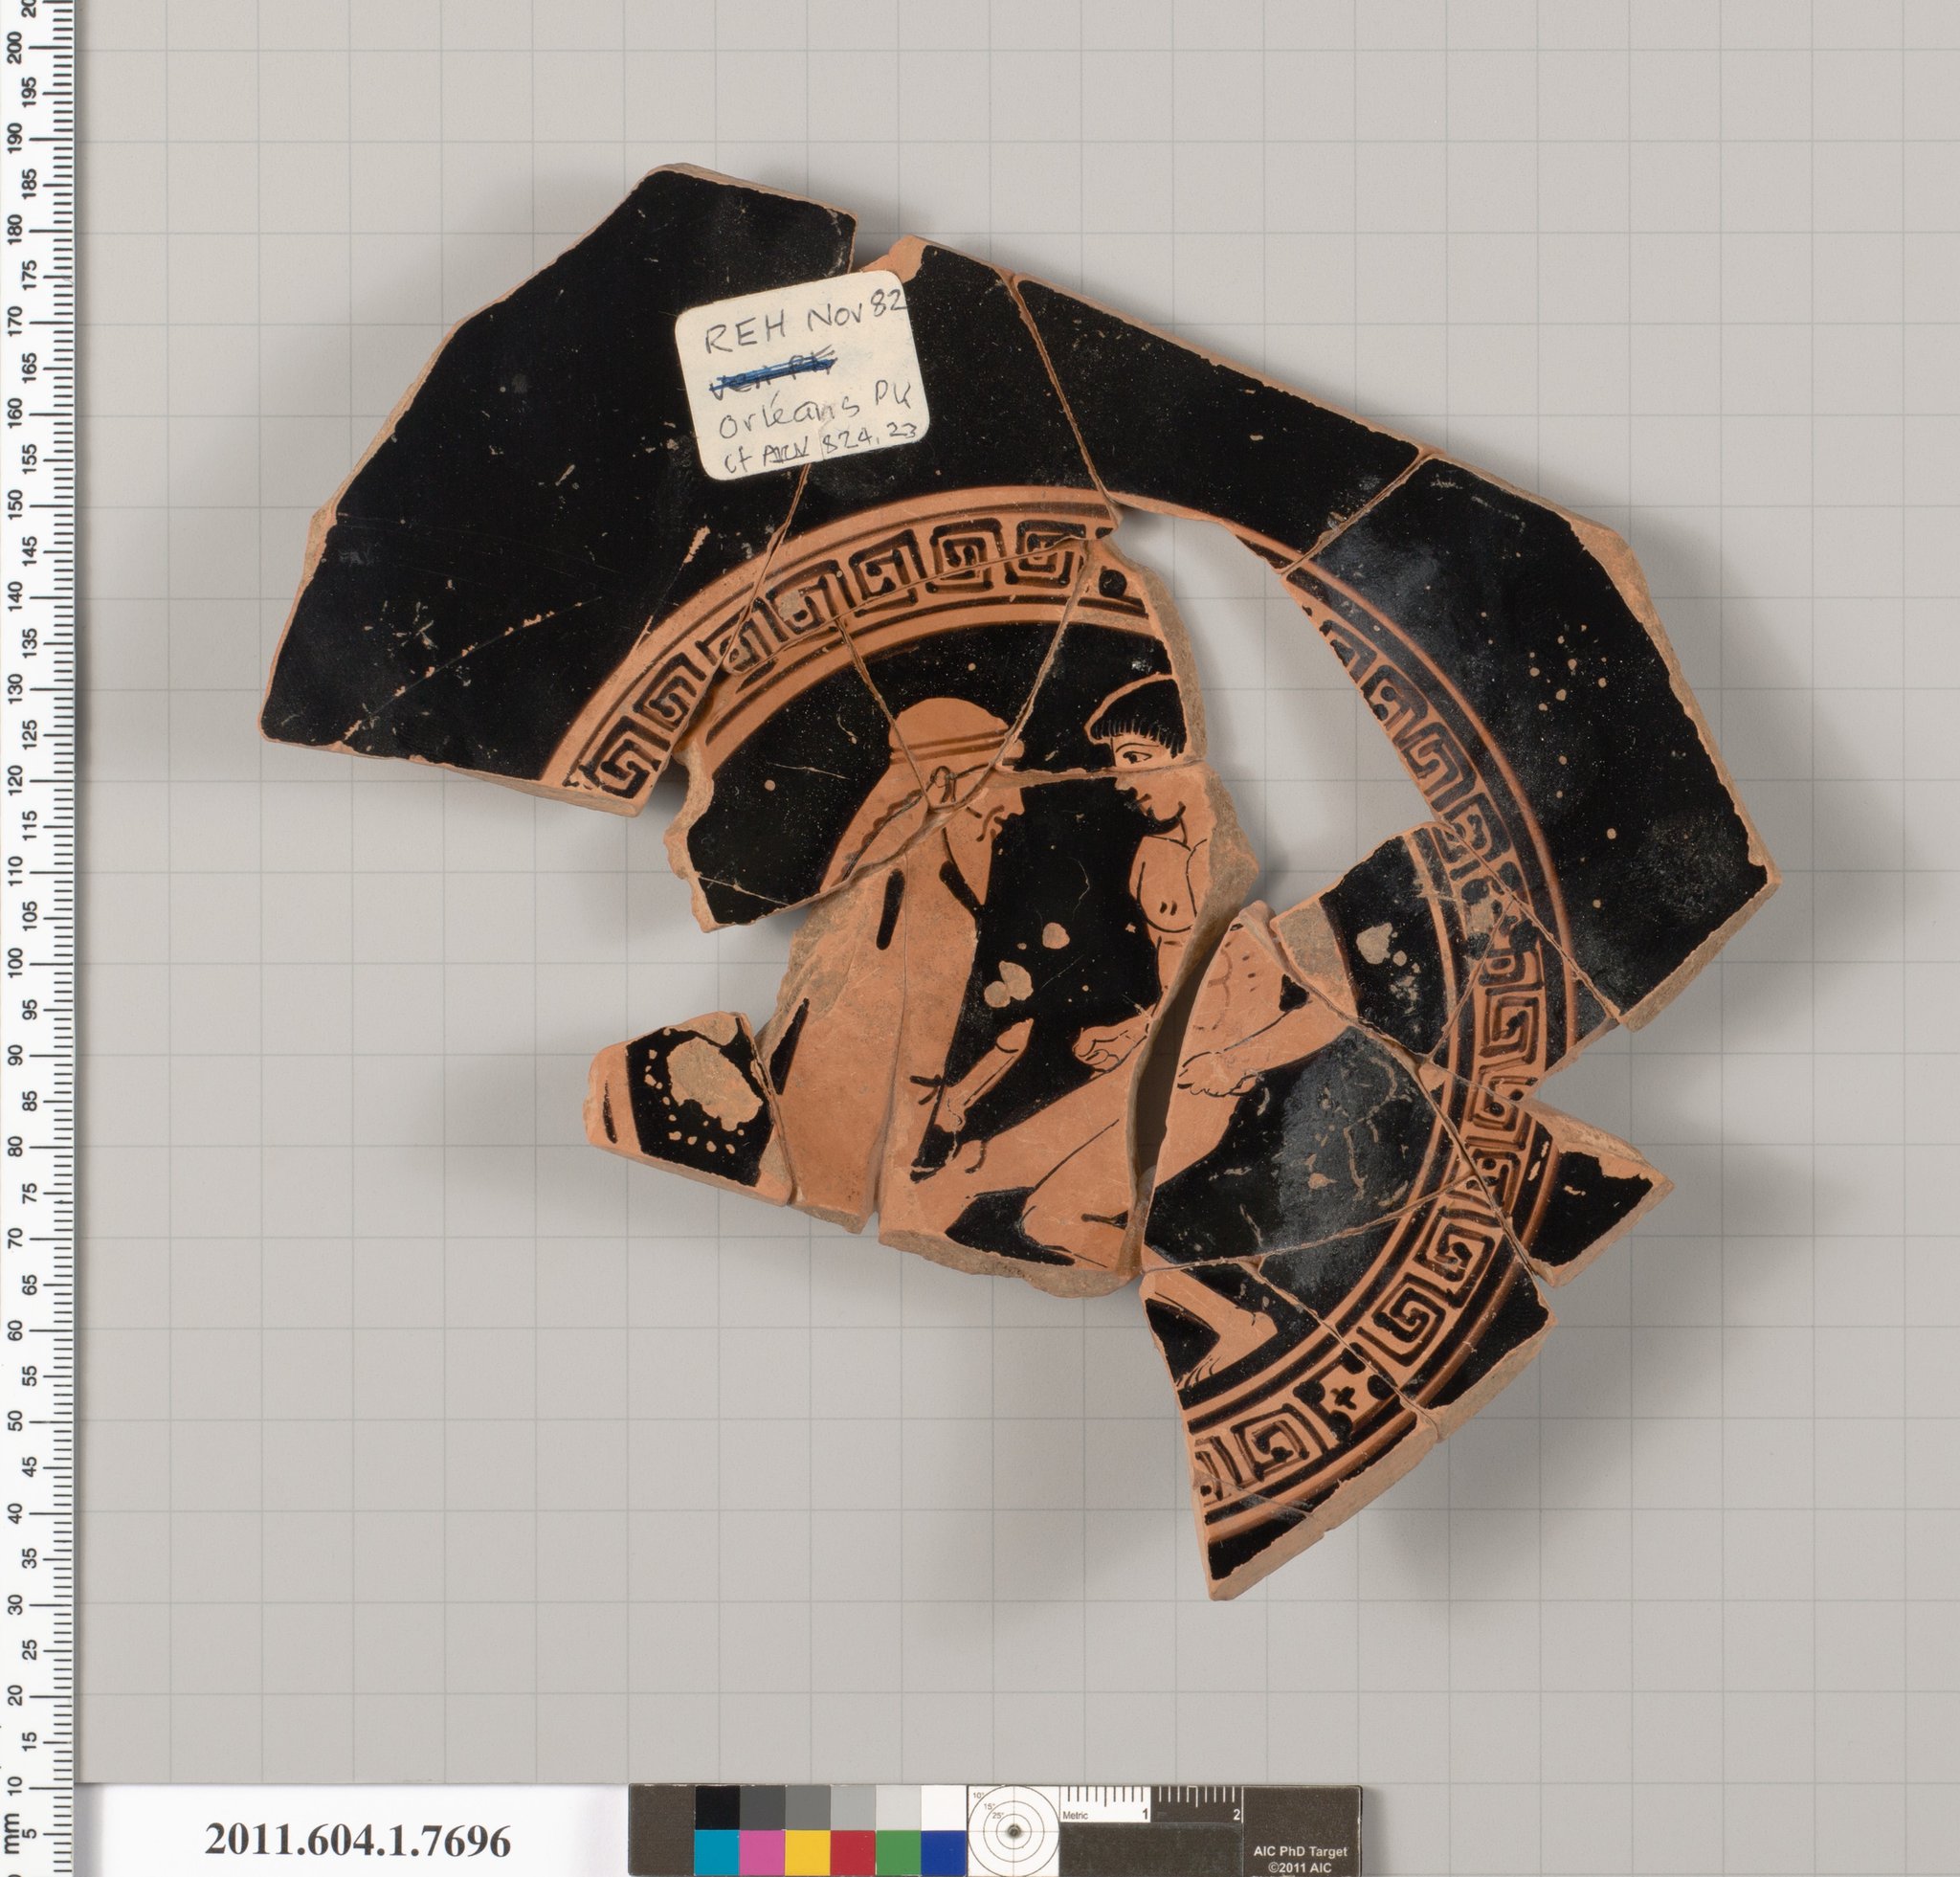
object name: kylix fragment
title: Terracotta fragment of a kylix (drinking cup)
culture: greek, attic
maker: orleans painter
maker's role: artist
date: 475-451 BCE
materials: terracotta